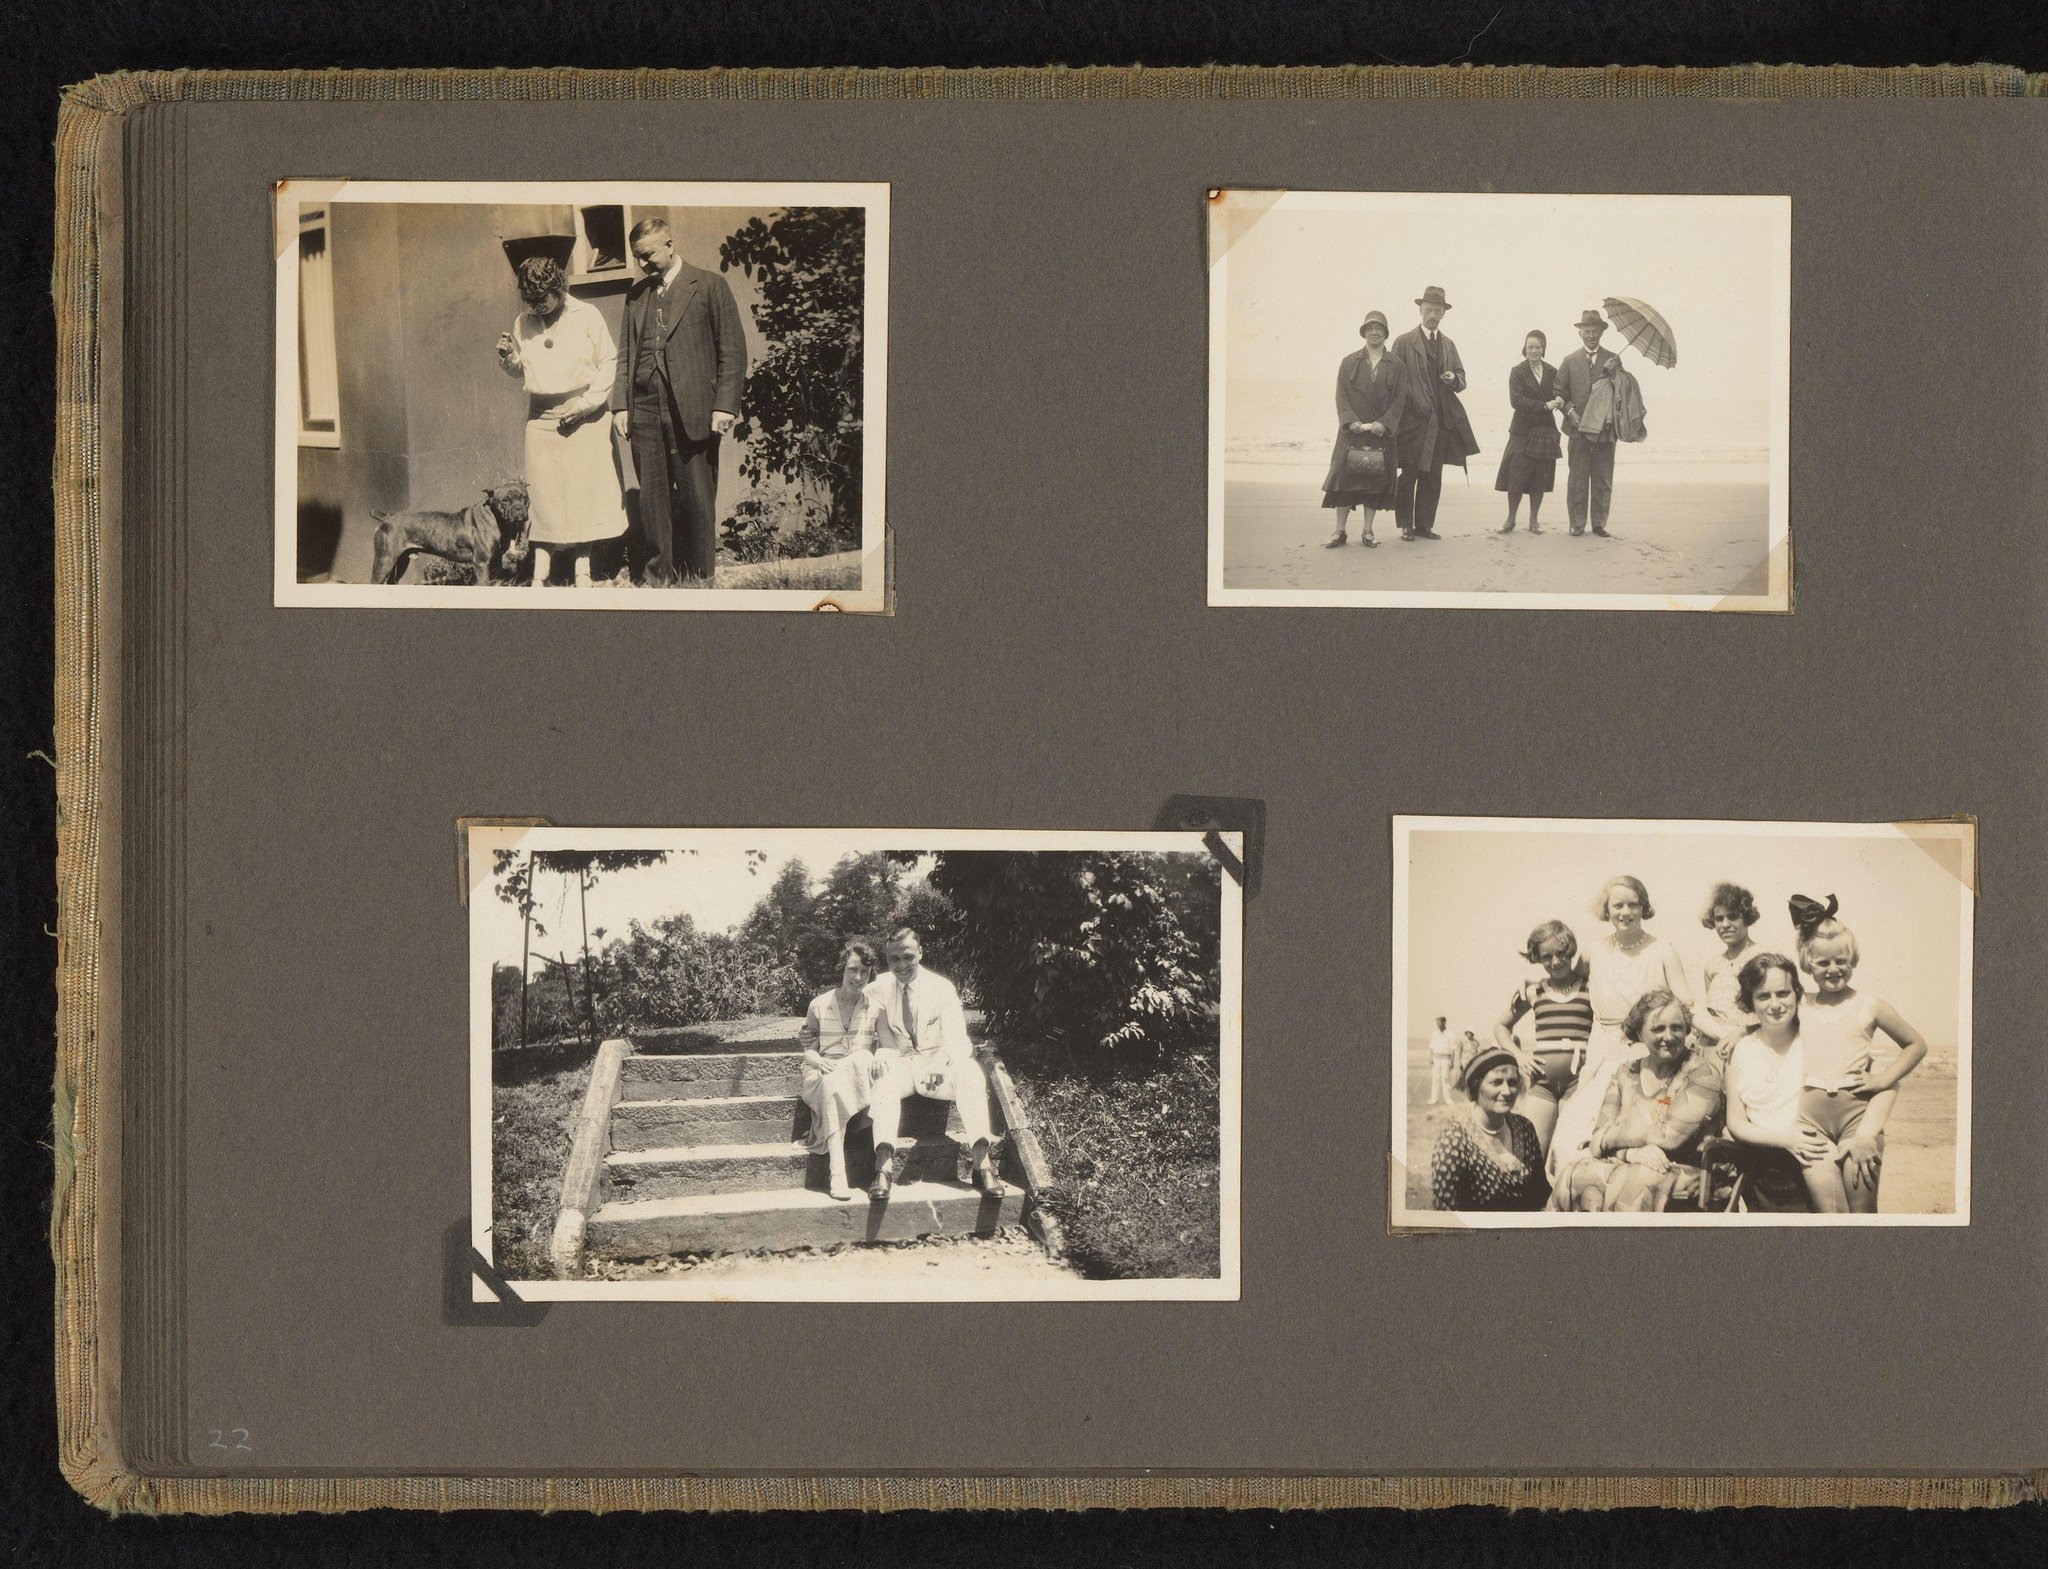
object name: photograph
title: Vrienden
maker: Anonymous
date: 1930-1931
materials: cardboard, photographic support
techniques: gelatin silver print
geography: netherlands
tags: beach (as place of recreation), student life, netherlands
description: Albumblad met vier groepsfoto's van bevriende families, enkele genomen op het strand. Onderdeel van fotoalbum 'Studentenalbum Indologen'.